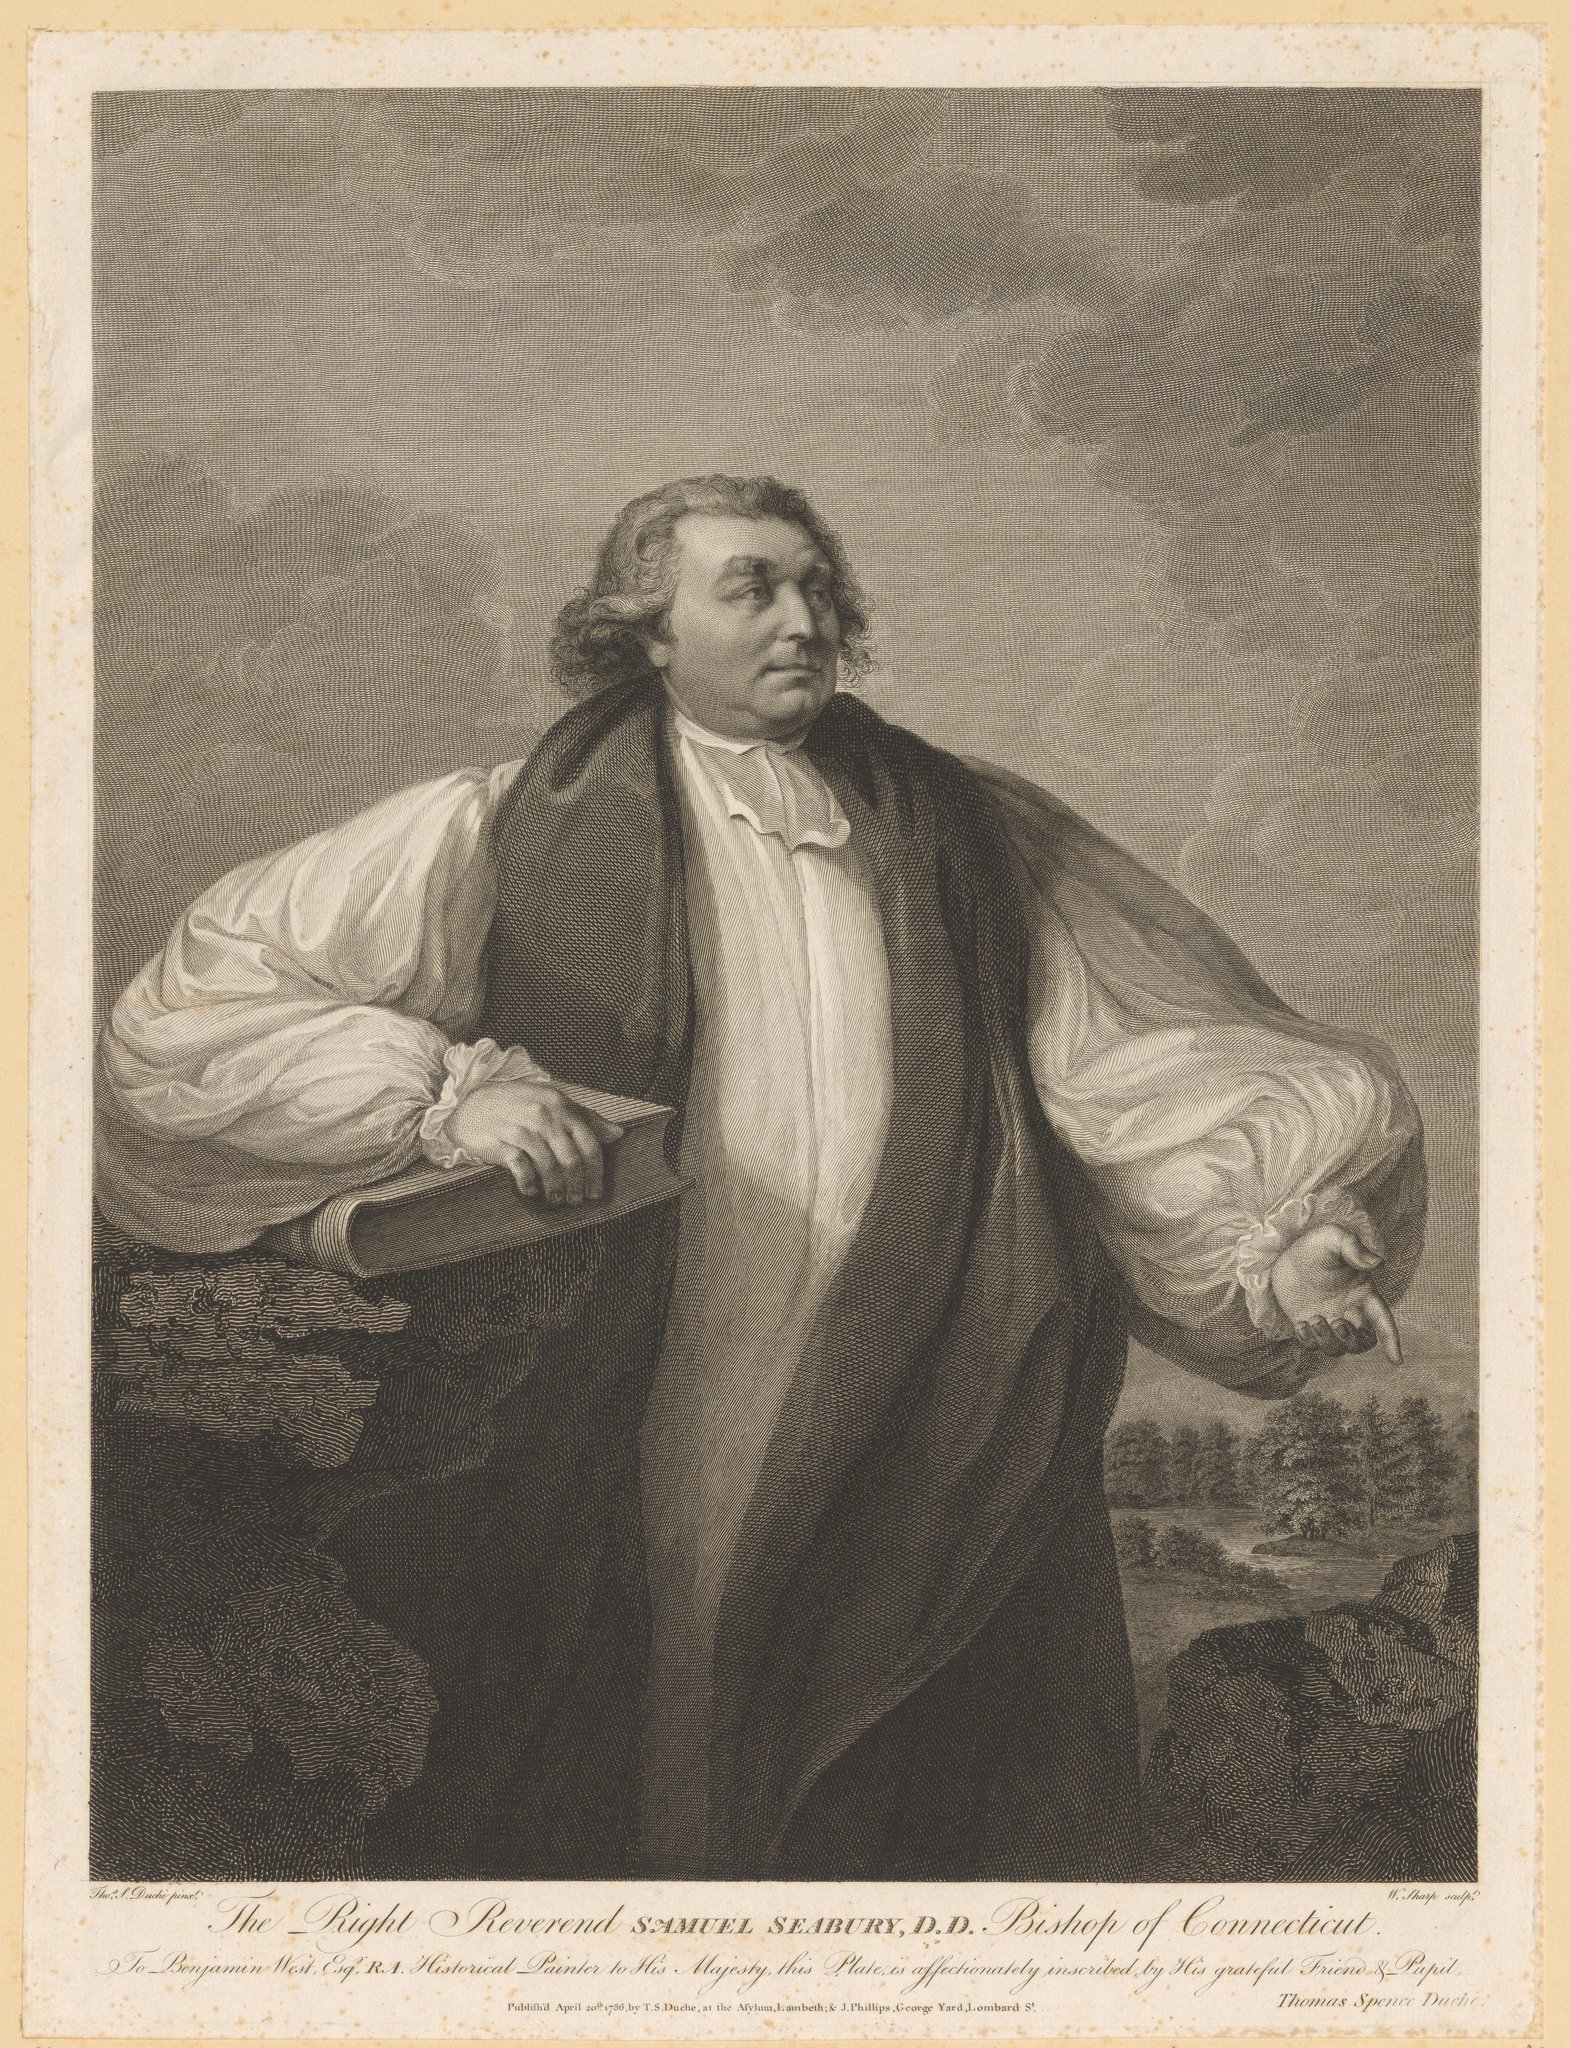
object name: print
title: Portret van Samuel Seabury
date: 1786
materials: paper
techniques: engraving, etching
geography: london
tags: archbishop, bishop, etc. (roman catholic), historical persons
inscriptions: collector's mark: Lugt 12